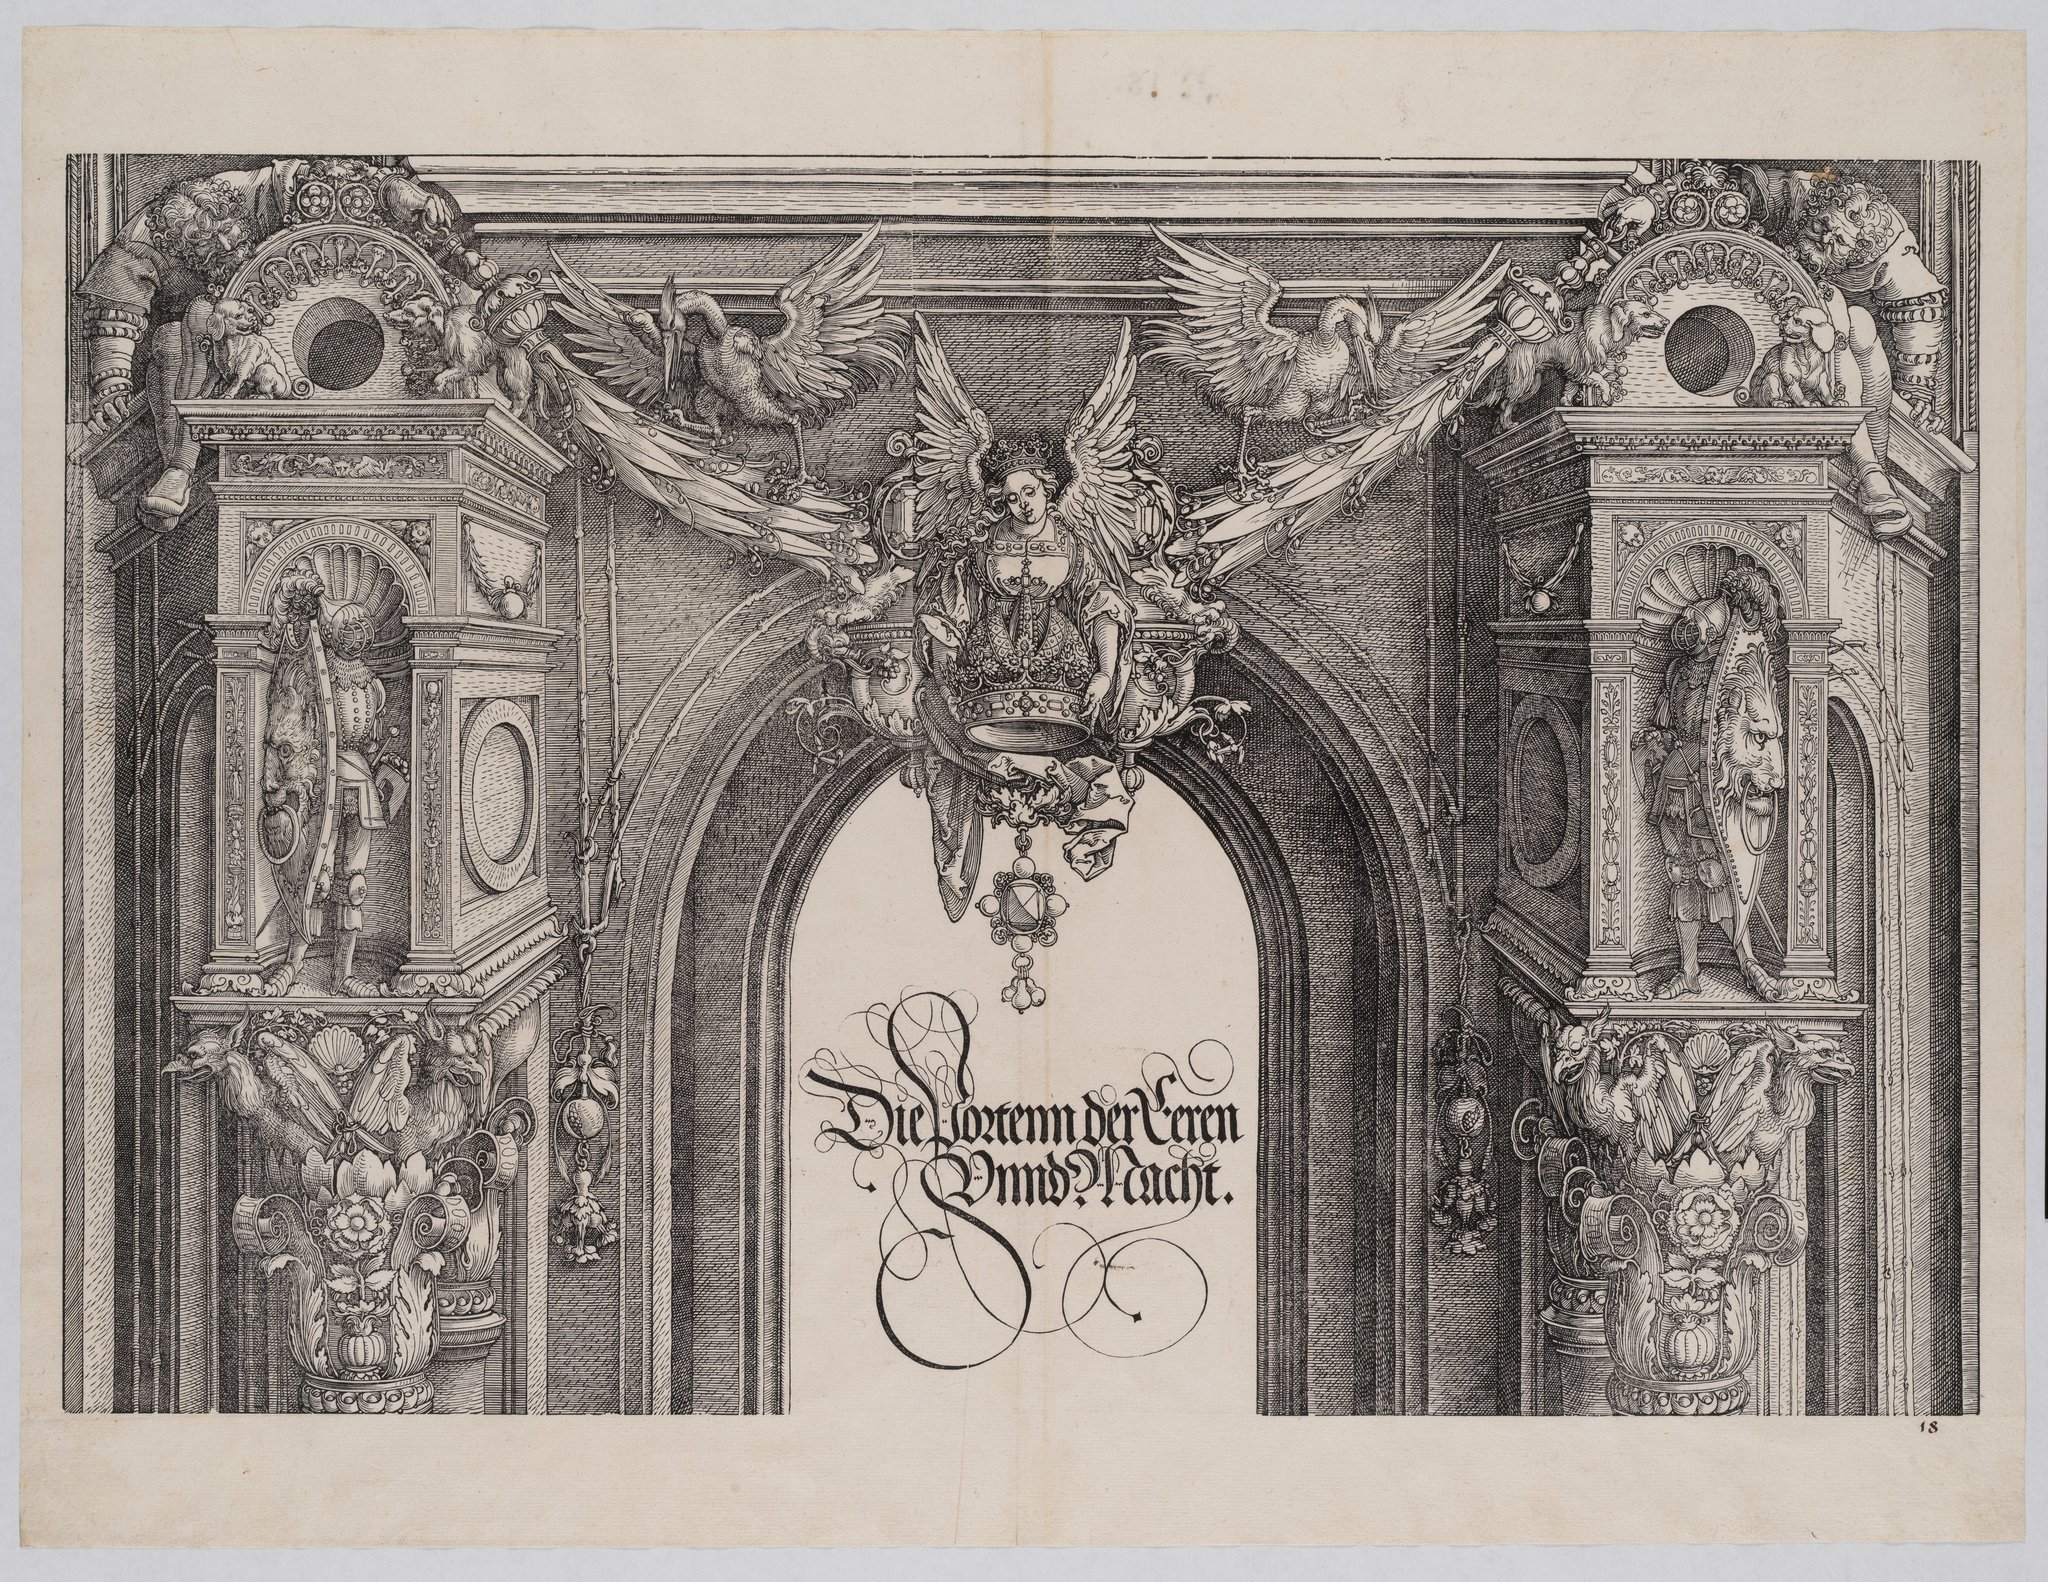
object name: print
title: The Upper Section of the Entryway to the Central Portal with a Winged Figure Holding the Imperial Crown, from the Arch of Honor, proof, dated 1515, printed 1517-18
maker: albrecht dürer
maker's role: artist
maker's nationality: german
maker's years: 1471-1528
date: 1515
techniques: letterpress, woodcut